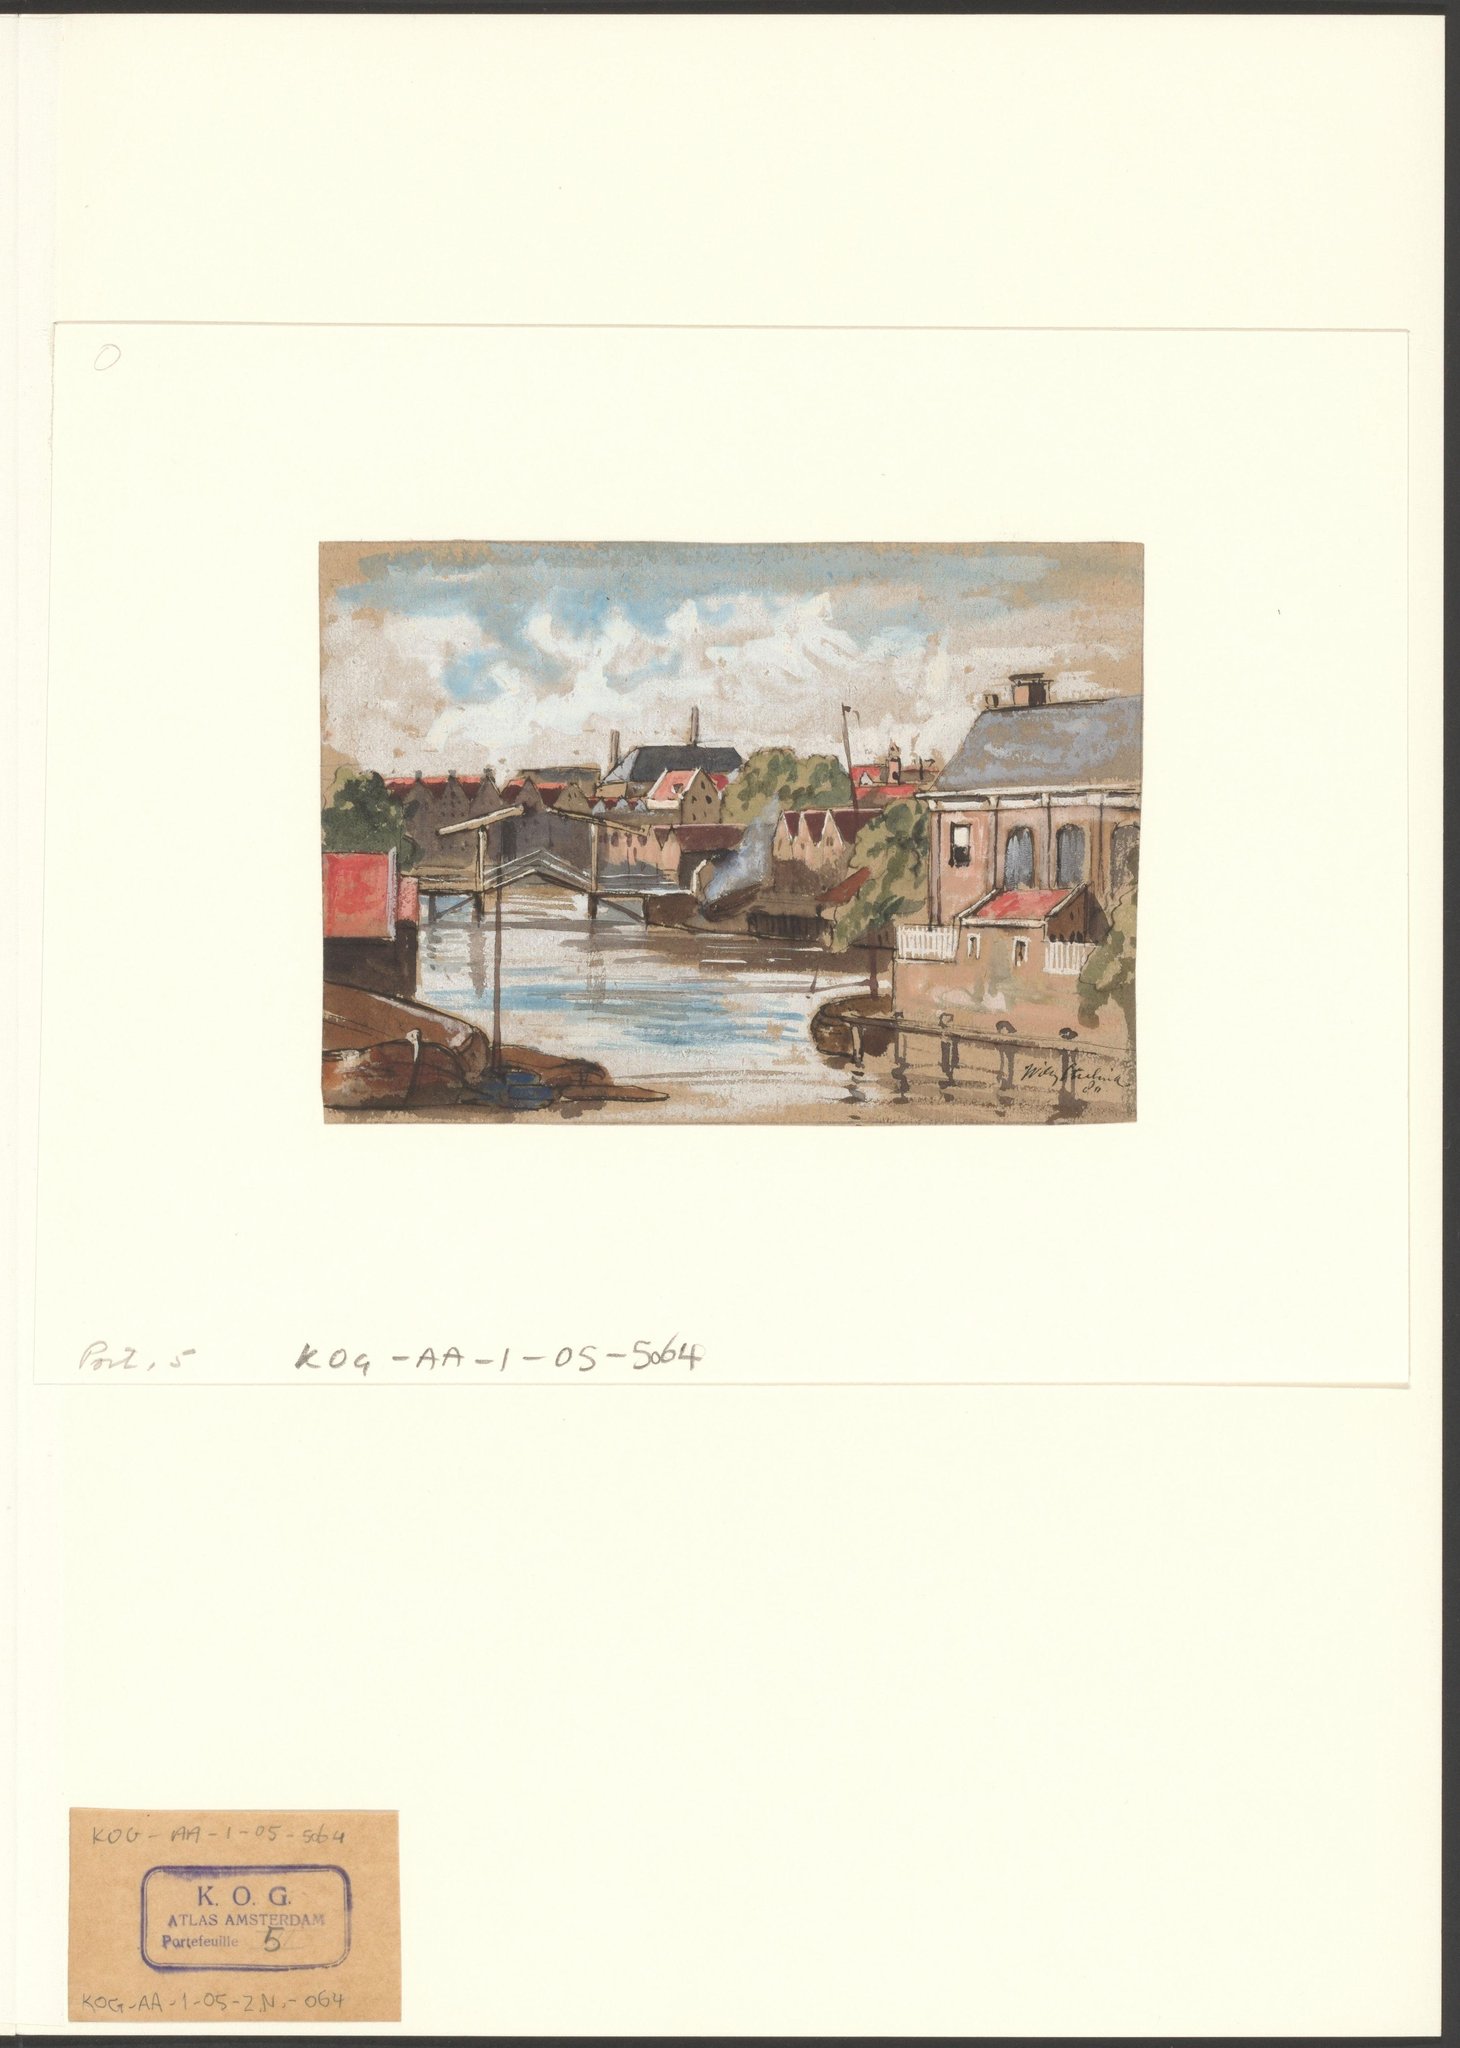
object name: drawing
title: Gezicht op de Bickersgracht, gezien vanuit de Haarlemmer Houttuinen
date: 1880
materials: paint, gouache, ink, paper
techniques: brush, pen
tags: city-view in general; 'veduta', canal, bridge in city across river, canal, etc.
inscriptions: signature and date: ‘Wilm Steelink / 80.’, collector's mark: ‘5’ Lugt 1641b, inscription: ‘Port. 5’, inscription: ‘de Bickersgracht / over (...) is de Houttuinen’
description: Onderwerpsrubriek binnen de Atlas Amsterdam: Begijnensloot (Gedempte), Bagijnhofsteeg, Beulingsloot, Bickersgracht en –plein, Bickersstraat (Groote), Bilderdijkskade en -straat, Binnenkant, Blauwburgwal, Boomdwarsstraat, Brouwersgracht, Bleekersspad (Lange), Bleekerssloot, Bloemgracht, Boerenwetering, Boltensgrachtje, Boomssloot (Recht), Badhuisweg.